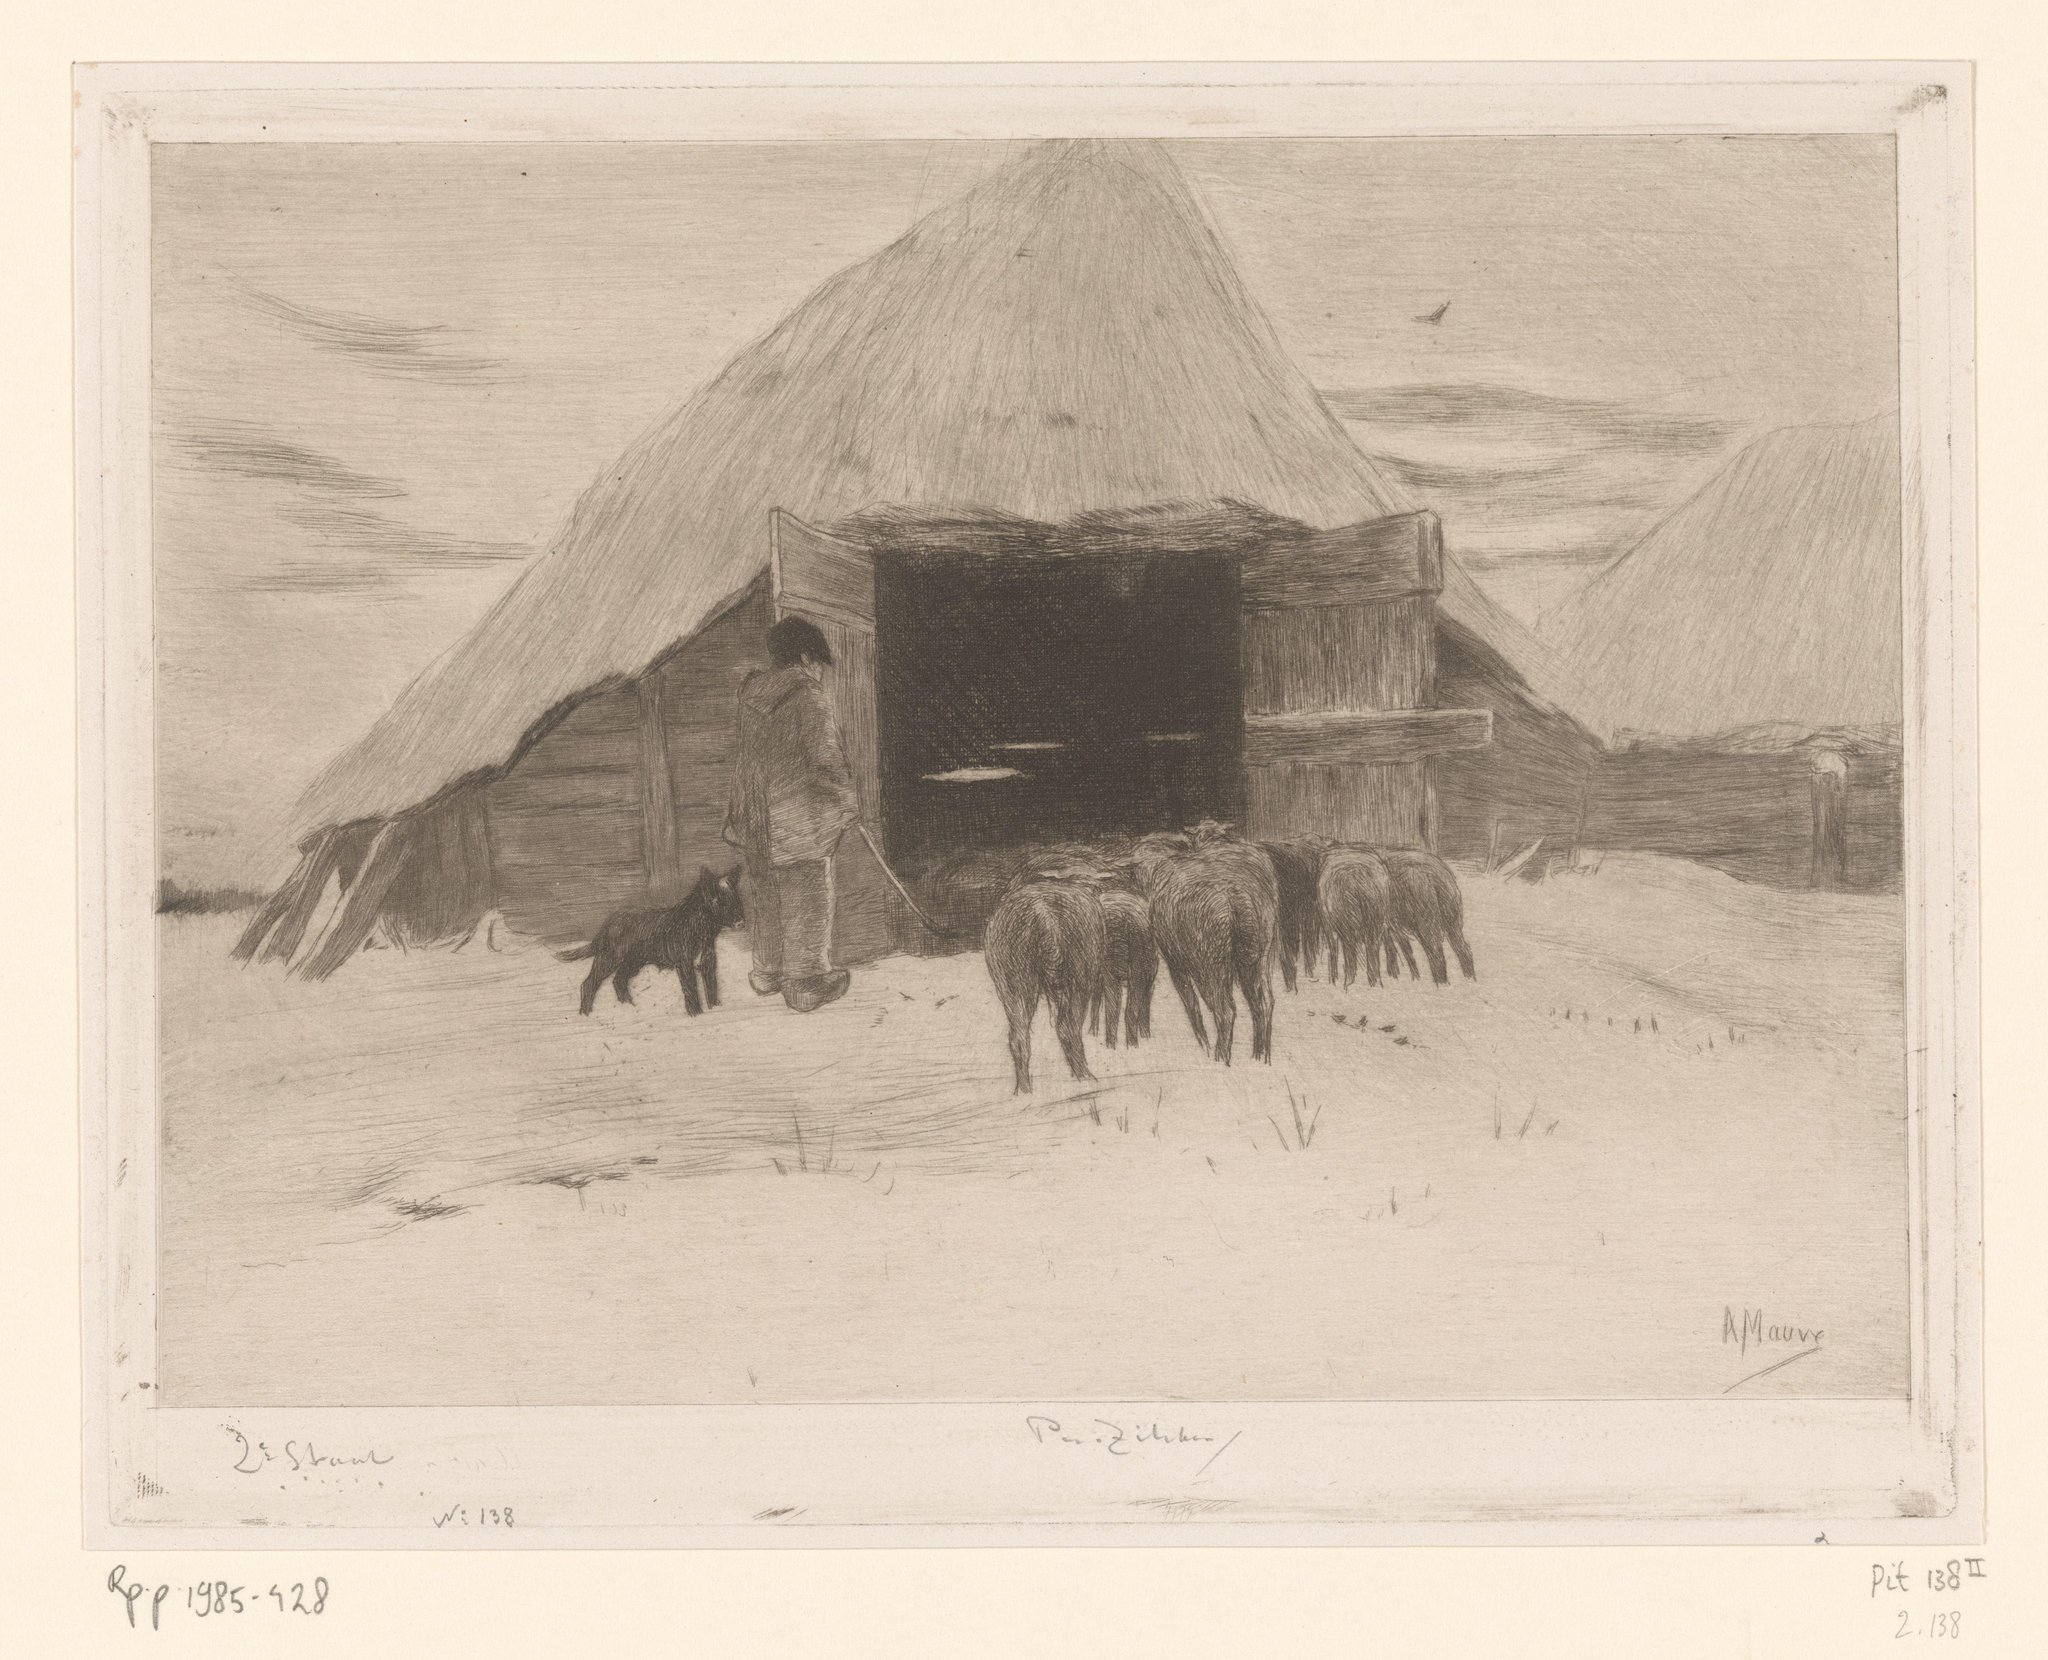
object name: print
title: De Liedjes-sangster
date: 1782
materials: paper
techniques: etching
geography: dordrecht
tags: performance in the open air (pleasure fair), ballad singer, ballad seller - cc - out of doors, festivities (+ music and song ~ festive activities)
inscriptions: collector's mark: Lugt 2760, collector's mark: Lugt 2228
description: Prent uit: Vaderlandsche Kermisvreugd vertoond in acht kunstplaaten geteekend en gegraveerd door K.F. Bendorp, met toepasselijke Vaersjes door R. Arends, H. de Haas en Compagnie (uitgever) Dordrecht 1782